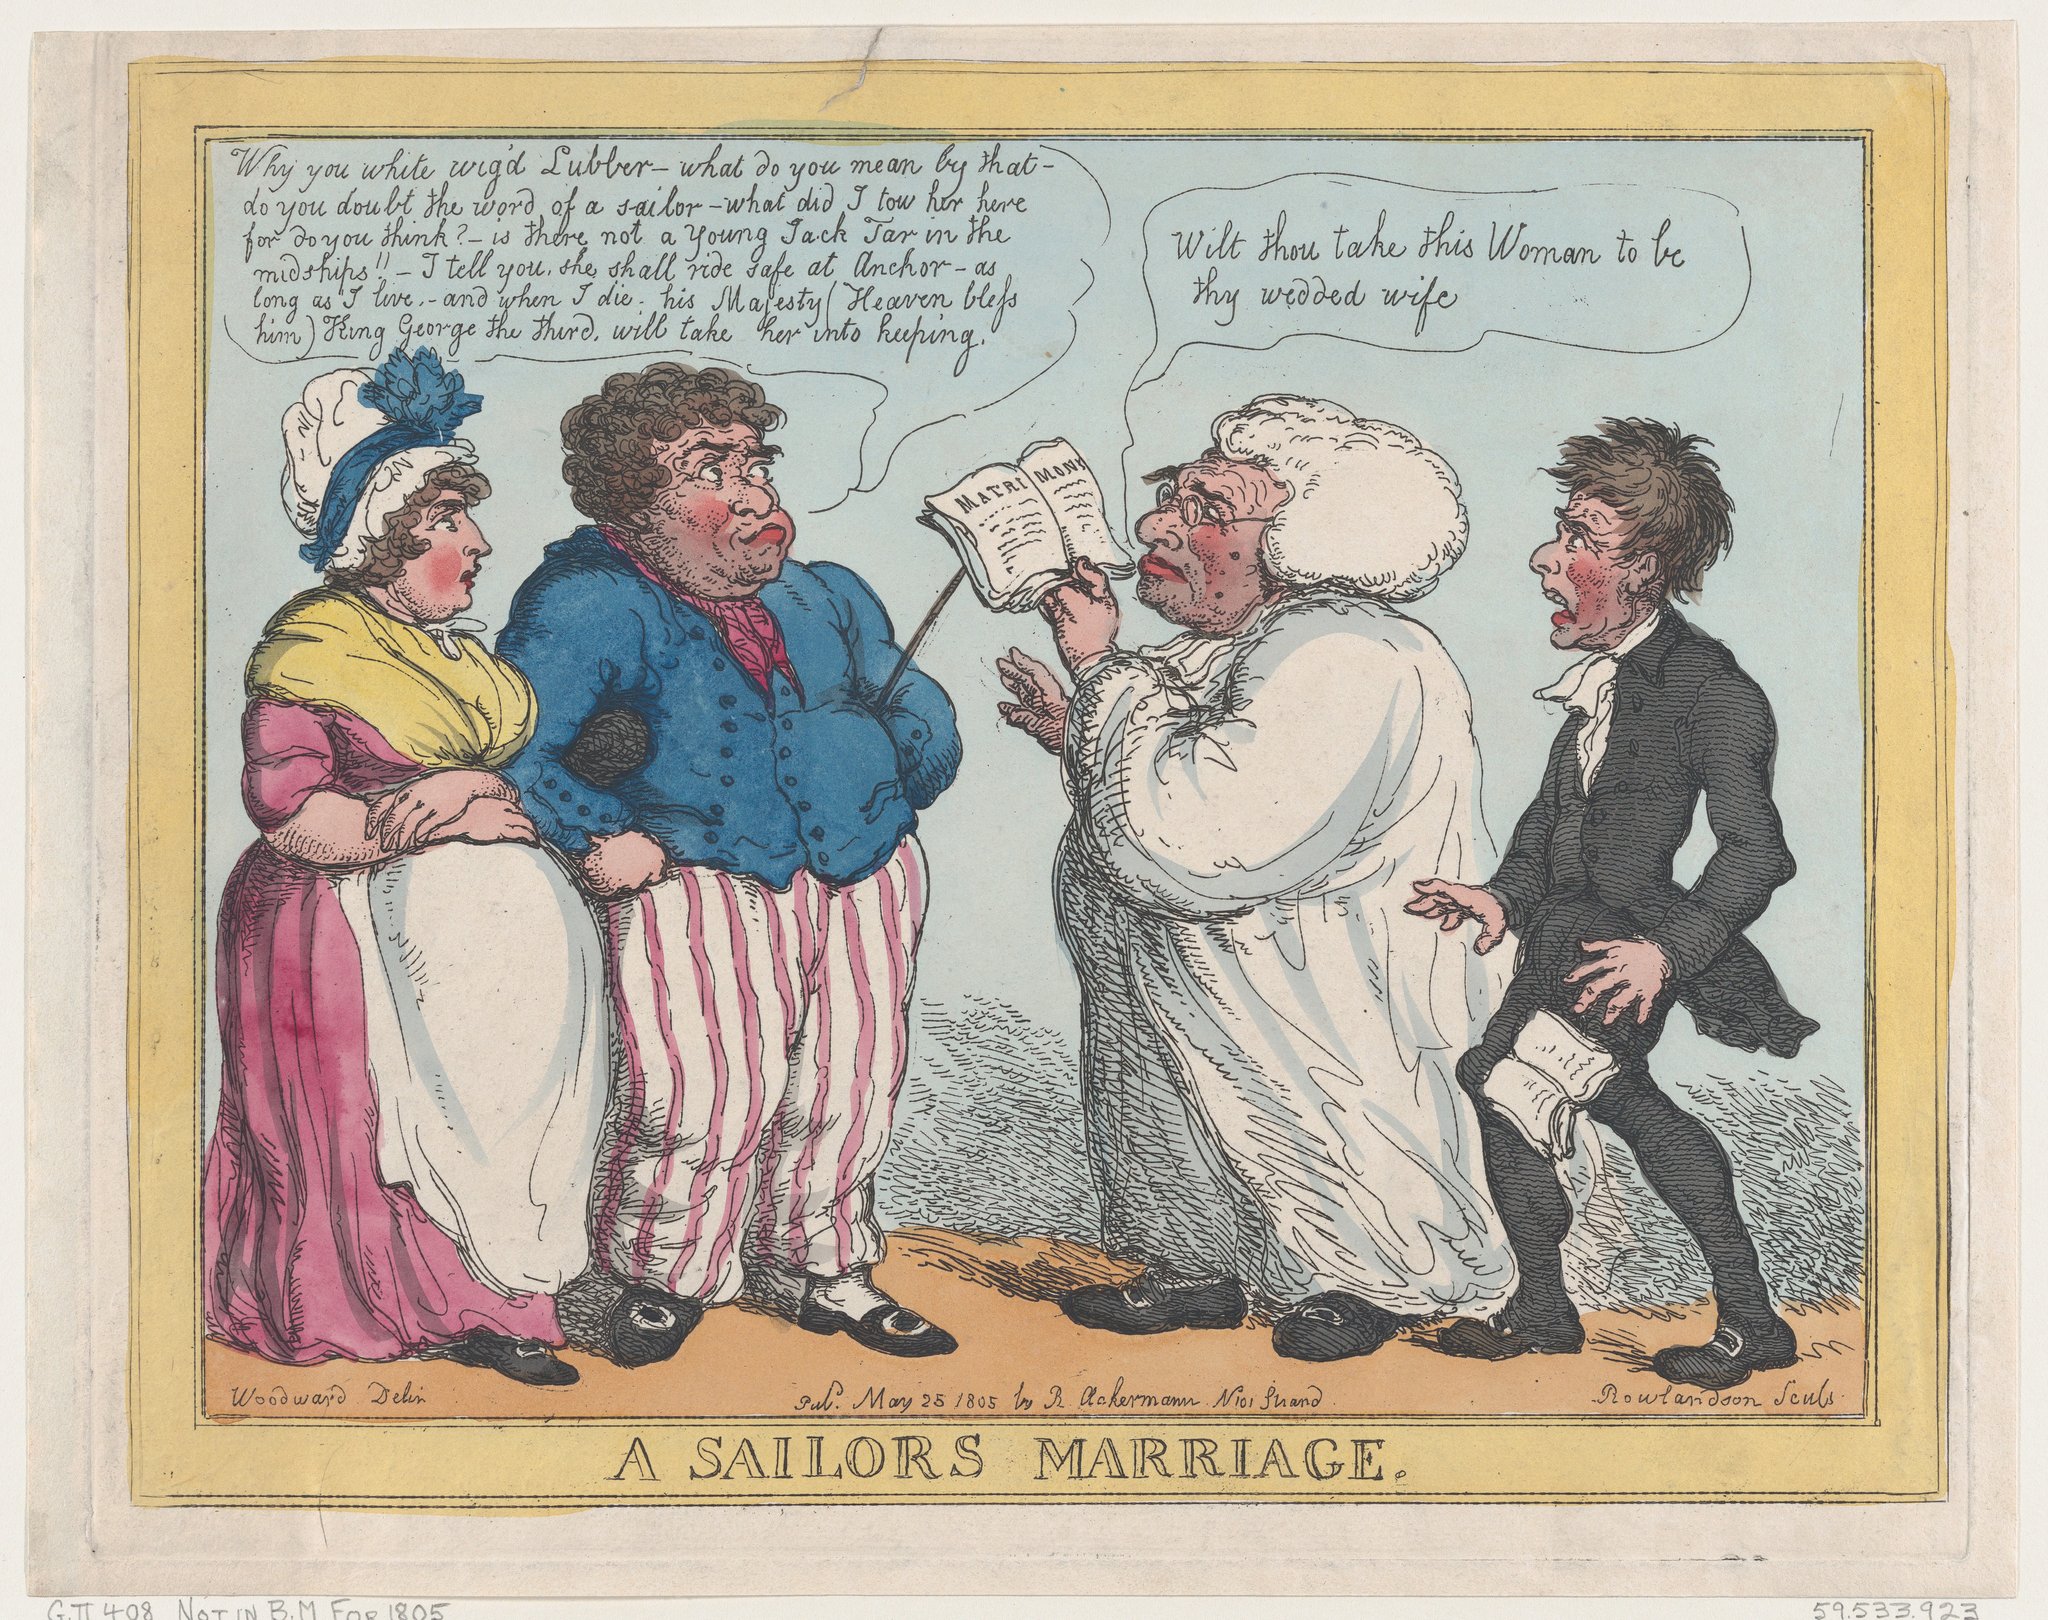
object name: print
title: A Sailor's Marriage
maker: thomas rowlandson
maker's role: artist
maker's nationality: british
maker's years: 1757-1827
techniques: etching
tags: satire,men,women